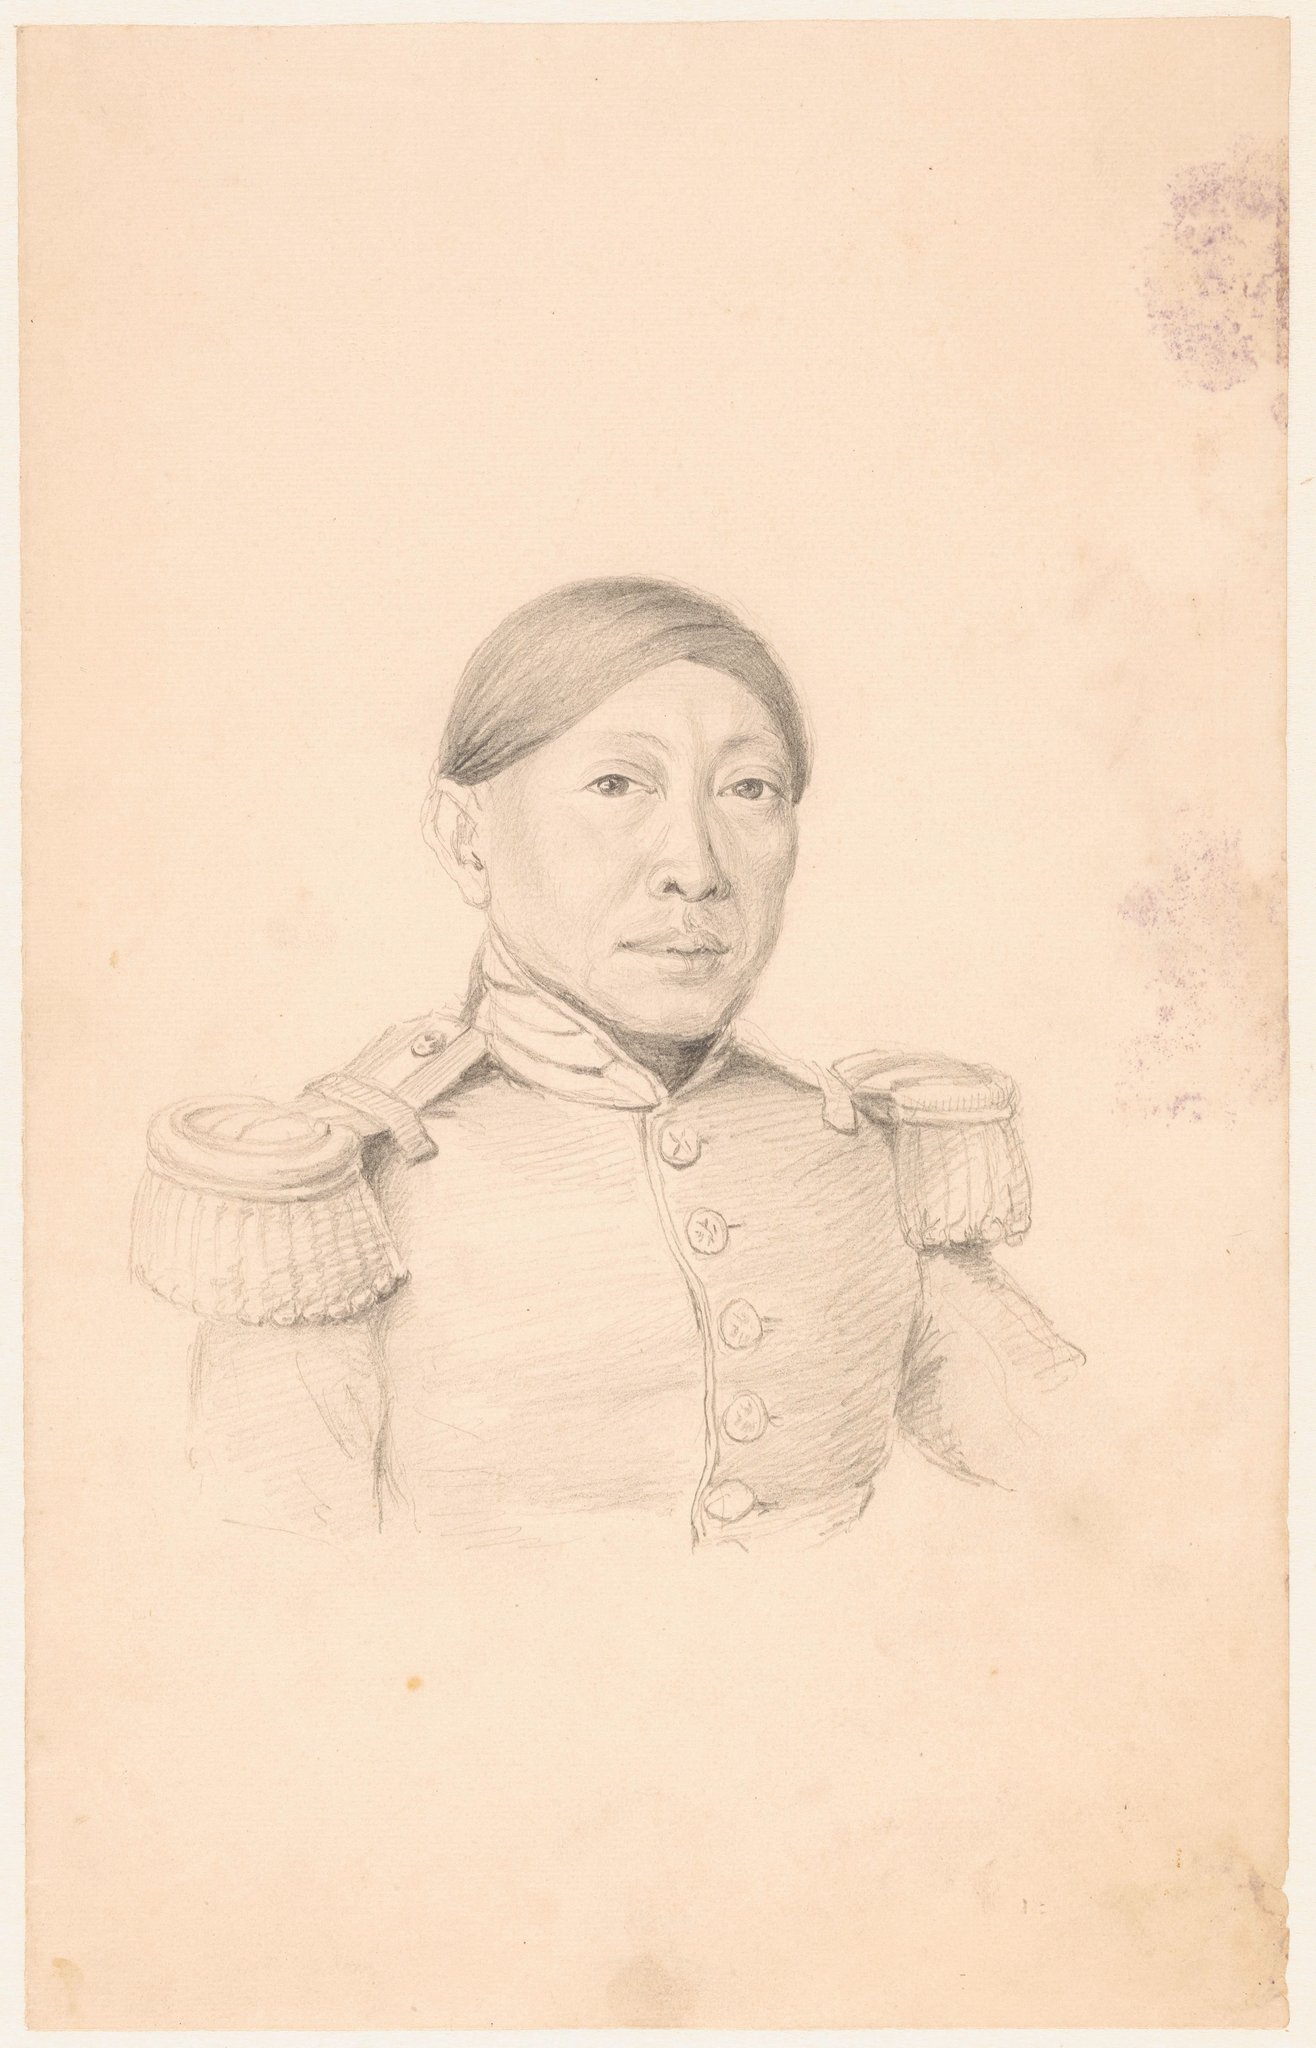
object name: drawing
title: Portret van een Javaanse funcionaris, in een uniform met epauletten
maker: christian heinrich gottlieb steuerwald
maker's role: draughtsman, print maker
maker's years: 1802-1874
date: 1848-1854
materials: paper, pencil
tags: asiatic races and peoples (indonesians), anonymous historical person portrayed alone